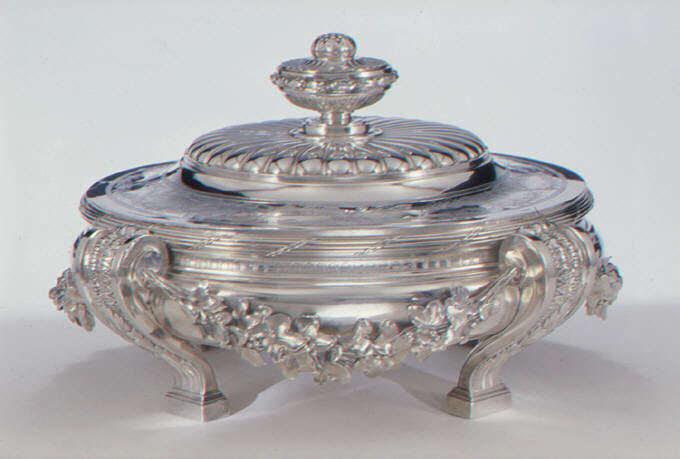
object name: dish with cover and liner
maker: jacques-nicolas roettiers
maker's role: maker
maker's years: 1736-1788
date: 1775-1776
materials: silver